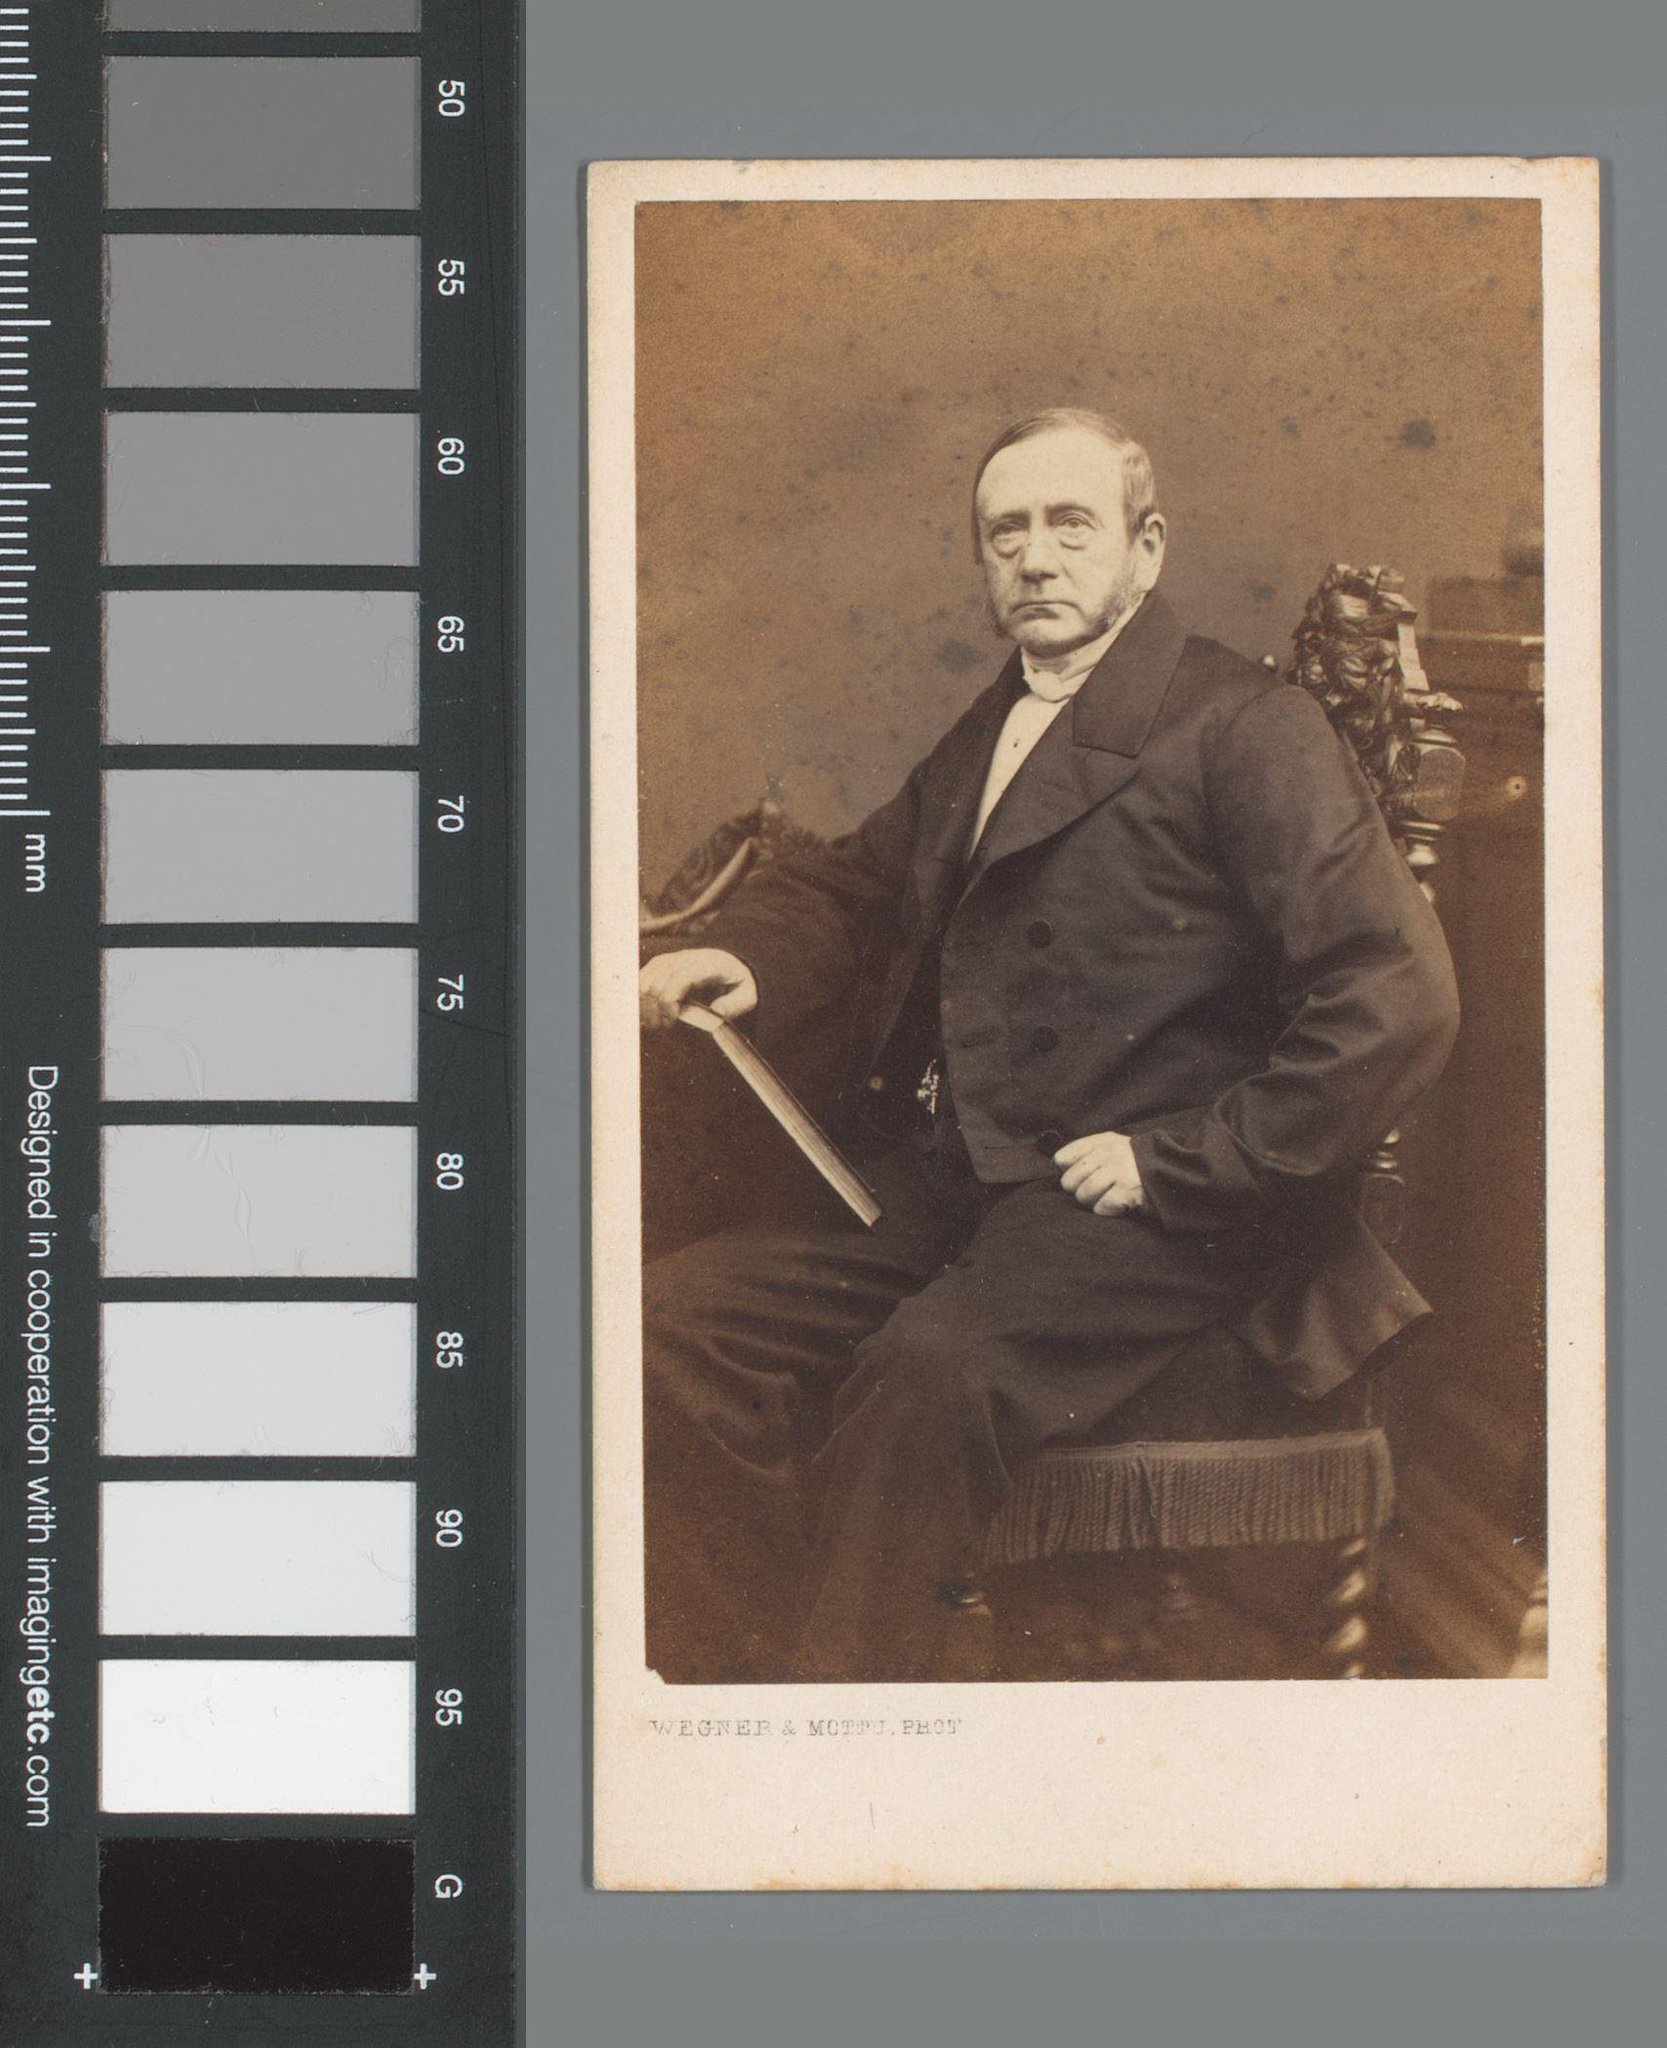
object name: carte de visite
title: Portret van de heer Nije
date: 1857-1864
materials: cardboard, photographic support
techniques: albumen print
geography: amsterdam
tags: historical persons, amsterdam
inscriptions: workshop stamp: ‘Photogr. Atelier/ Wegner & Mottu/ Prinsengracht BB, 439 Amsterdam’, annotation: ‘overgrootvader Nije’